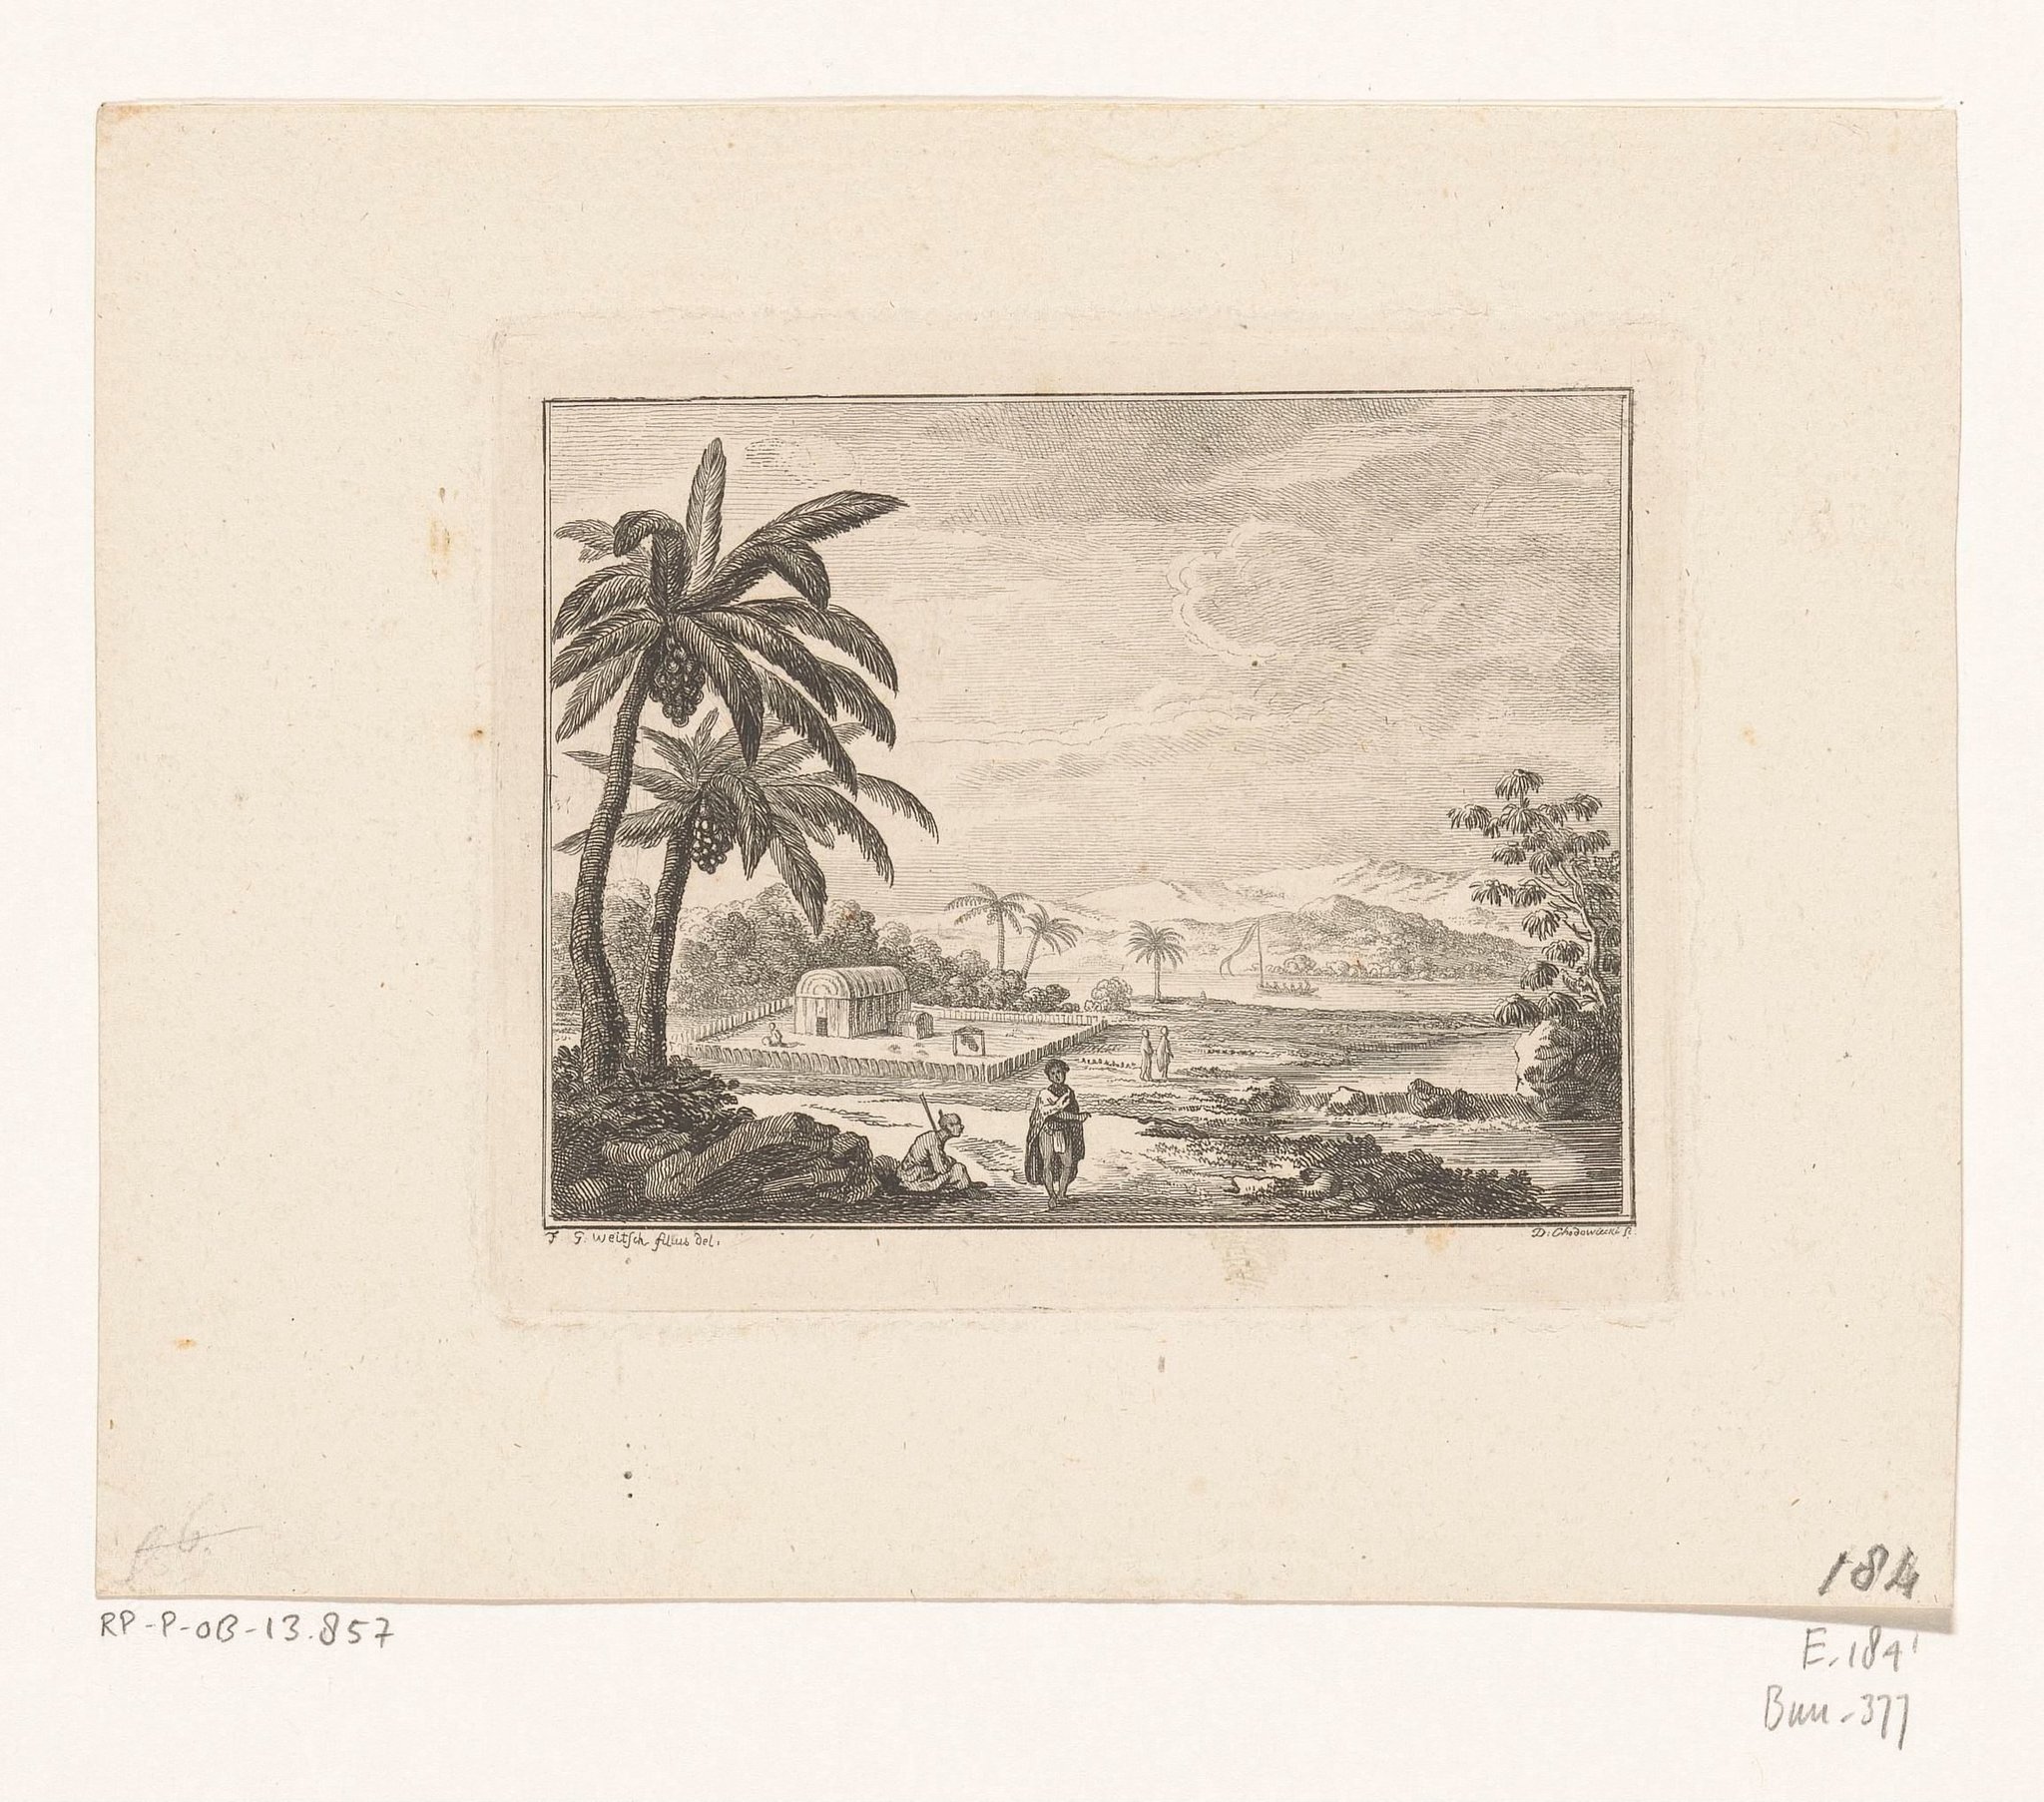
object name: print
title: Landschap op Tahiti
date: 1777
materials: paper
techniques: etching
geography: berlin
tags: trees: palm-tree, landscapes (+ landscape with figures, staffage)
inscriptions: collector's mark: Lugt 2228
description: Prent ook gebruikt Zachariä, Friedrich Wilhelm von. Tayti, oder die glückliche Insel. Braunschweig: Fürstlichen Waisenhaus-Buchhandlung, 1777.